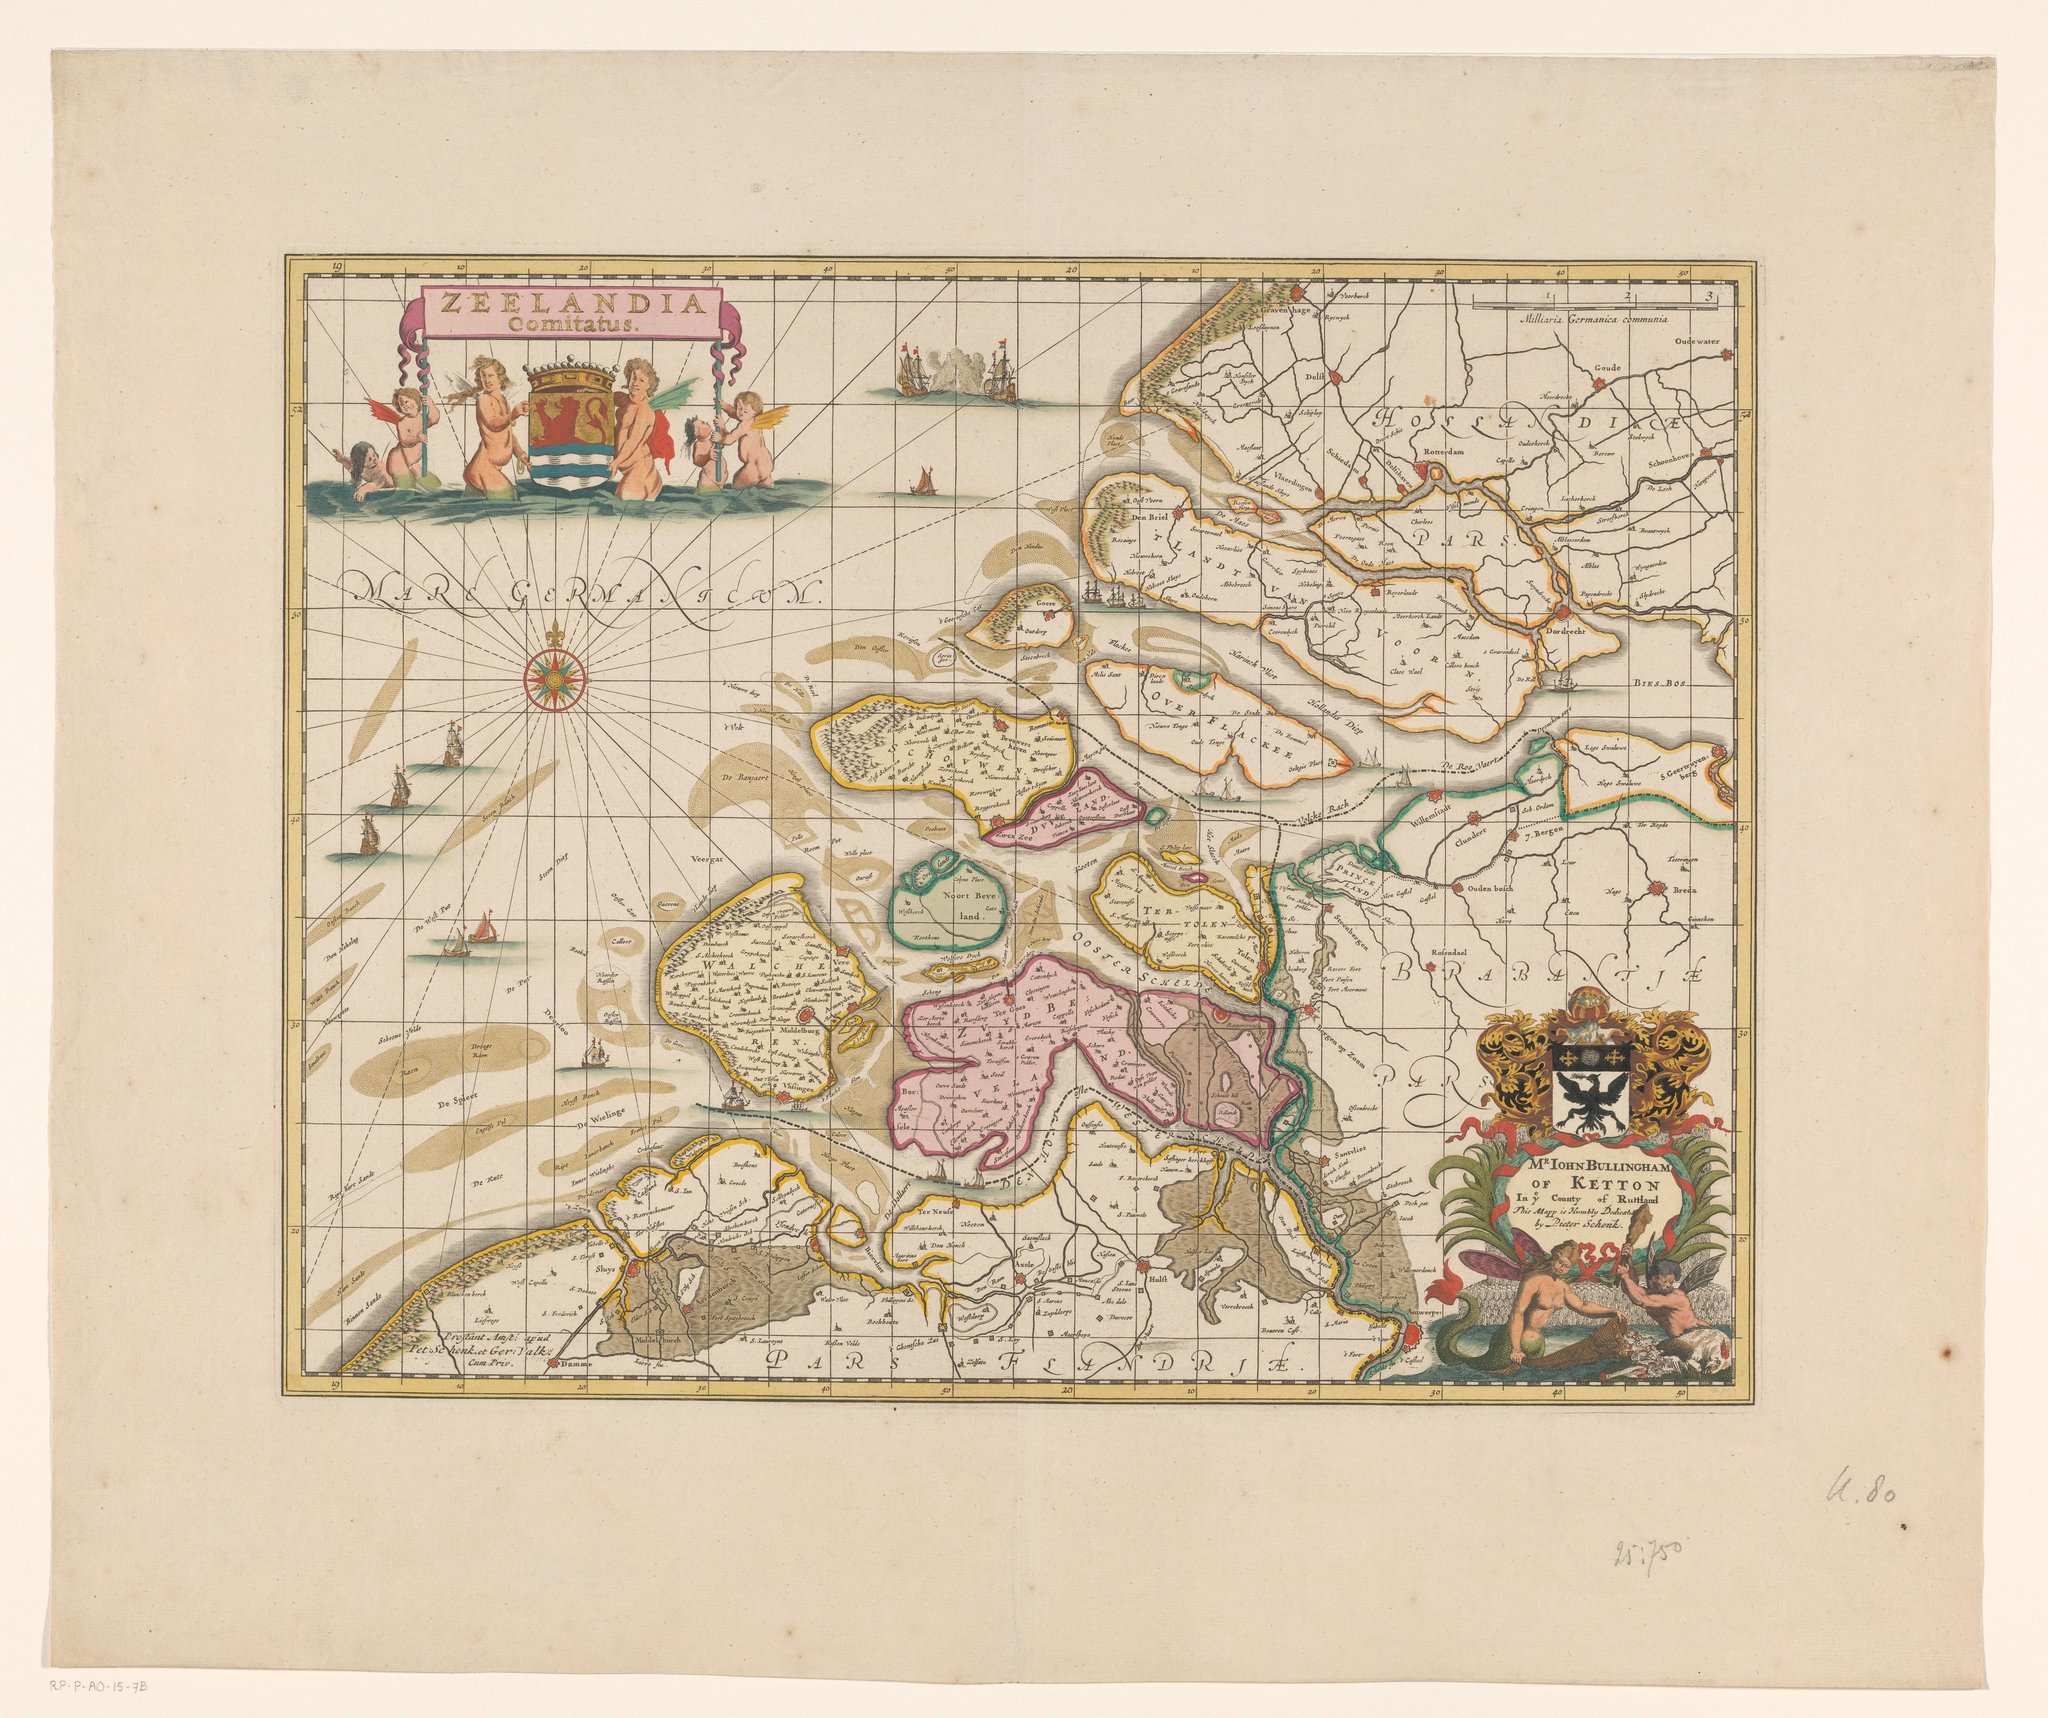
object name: print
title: Kaart van Zeeland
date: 1636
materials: paint, paper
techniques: brush, engraving, etching, hand coloring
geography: amsterdam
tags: triton(s), maps of separate countries or regions, merman - aa - mermaid, siren, coat of arms (as symbol of the state, etc.) (+ province; provincial), armorial bearing, heraldry, zeeland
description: Linksboven de titel en het wapen van Zeeland omringd door tritons. Rechtsboven een schaalstok: Milliaria Germanica communia. Rechtsonder een cartouche met de opdracht aan en het wapen van John Bullingham of Ketton. Daaronder een zeemeermin en een triton. De kaart is voorzien van een coördinaten-net en gradenverdeling langs de randen.